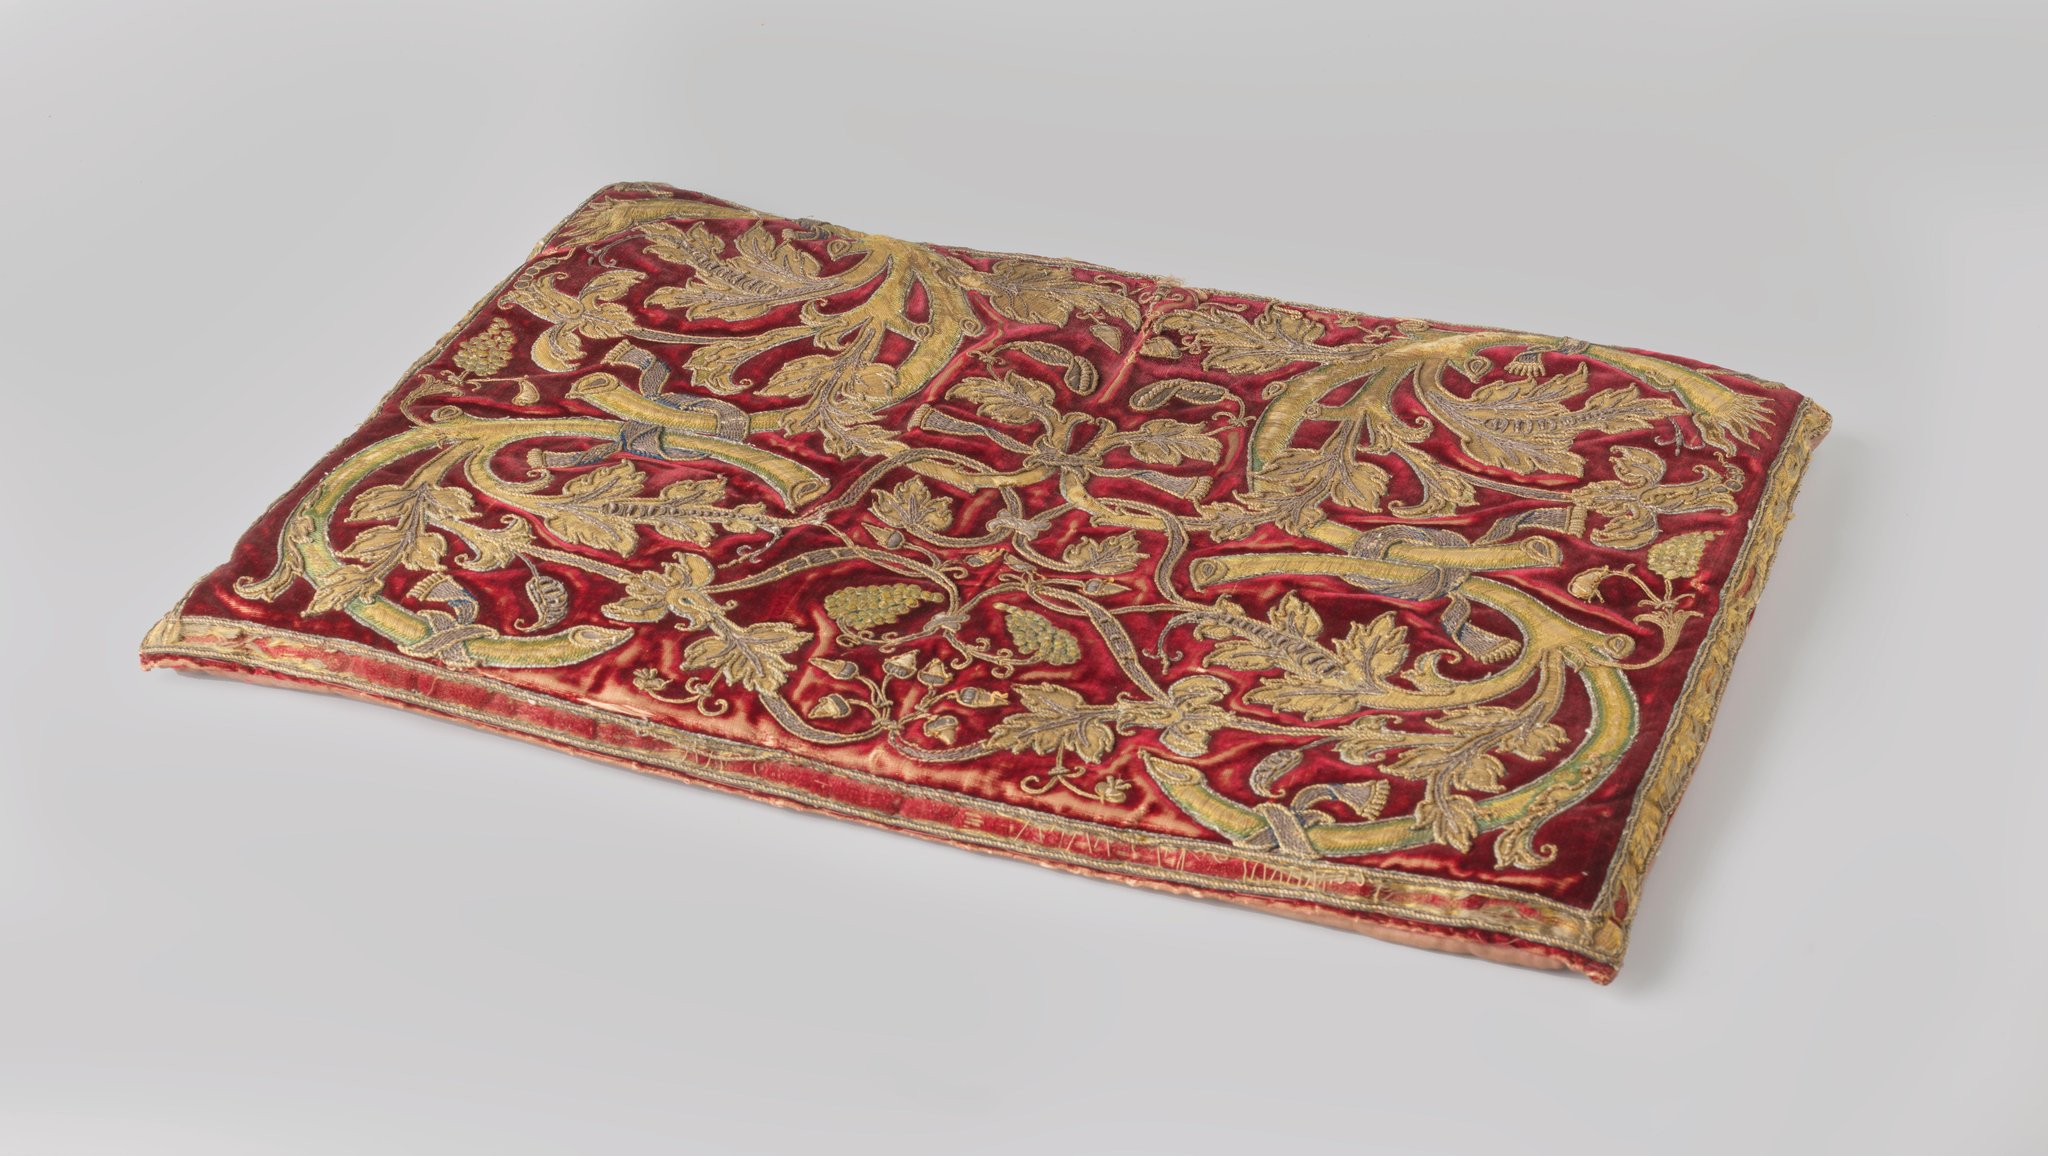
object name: embroidery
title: Stoelzitting met borduurwerk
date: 1500-1600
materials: thread, velvet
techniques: brocade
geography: italy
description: Stoelzitting van wijnrood fluweel met applicatie-borduurwerk. Aan de korte zijden staan afgeknotte takken omwonden door een lint. Zijtakken met acanthusblad en eindigend in lelie, eikels, korenaar en druiventrossen. Applicatie van goudbrokaat geborduurd met groene en gele zijde. Langs de contouren glegd goud en blauw koord. Bladnerven van zilverdraad.